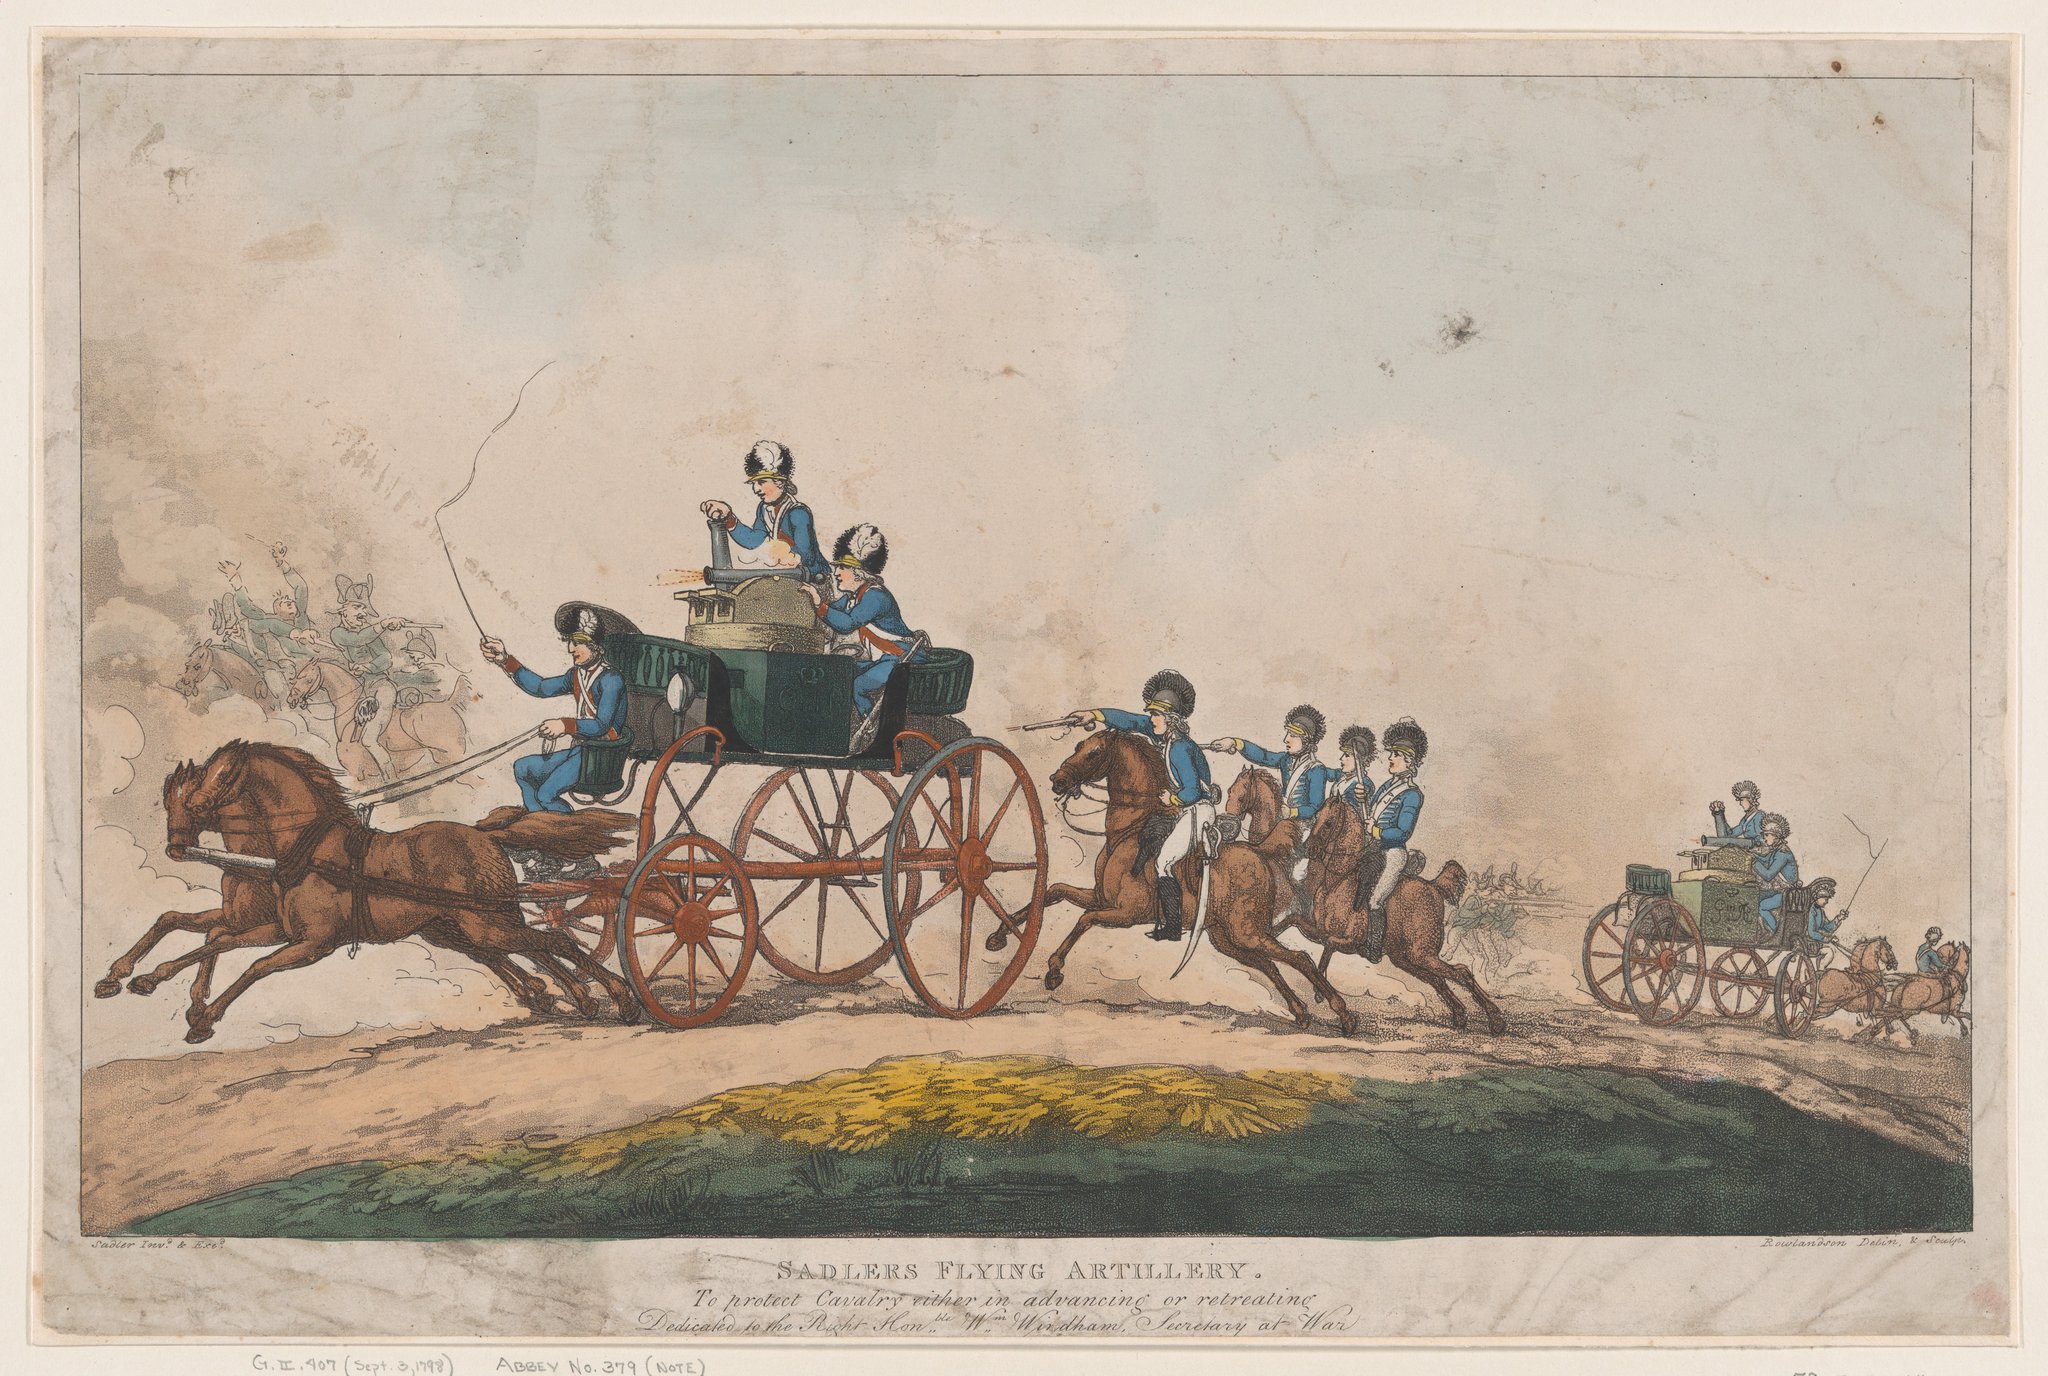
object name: print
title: Sadlers Flying Artillery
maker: thomas rowlandson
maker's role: artist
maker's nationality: british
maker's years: 1757-1827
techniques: aquatint, etching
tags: soldiers,weapons,men,horses,carriages